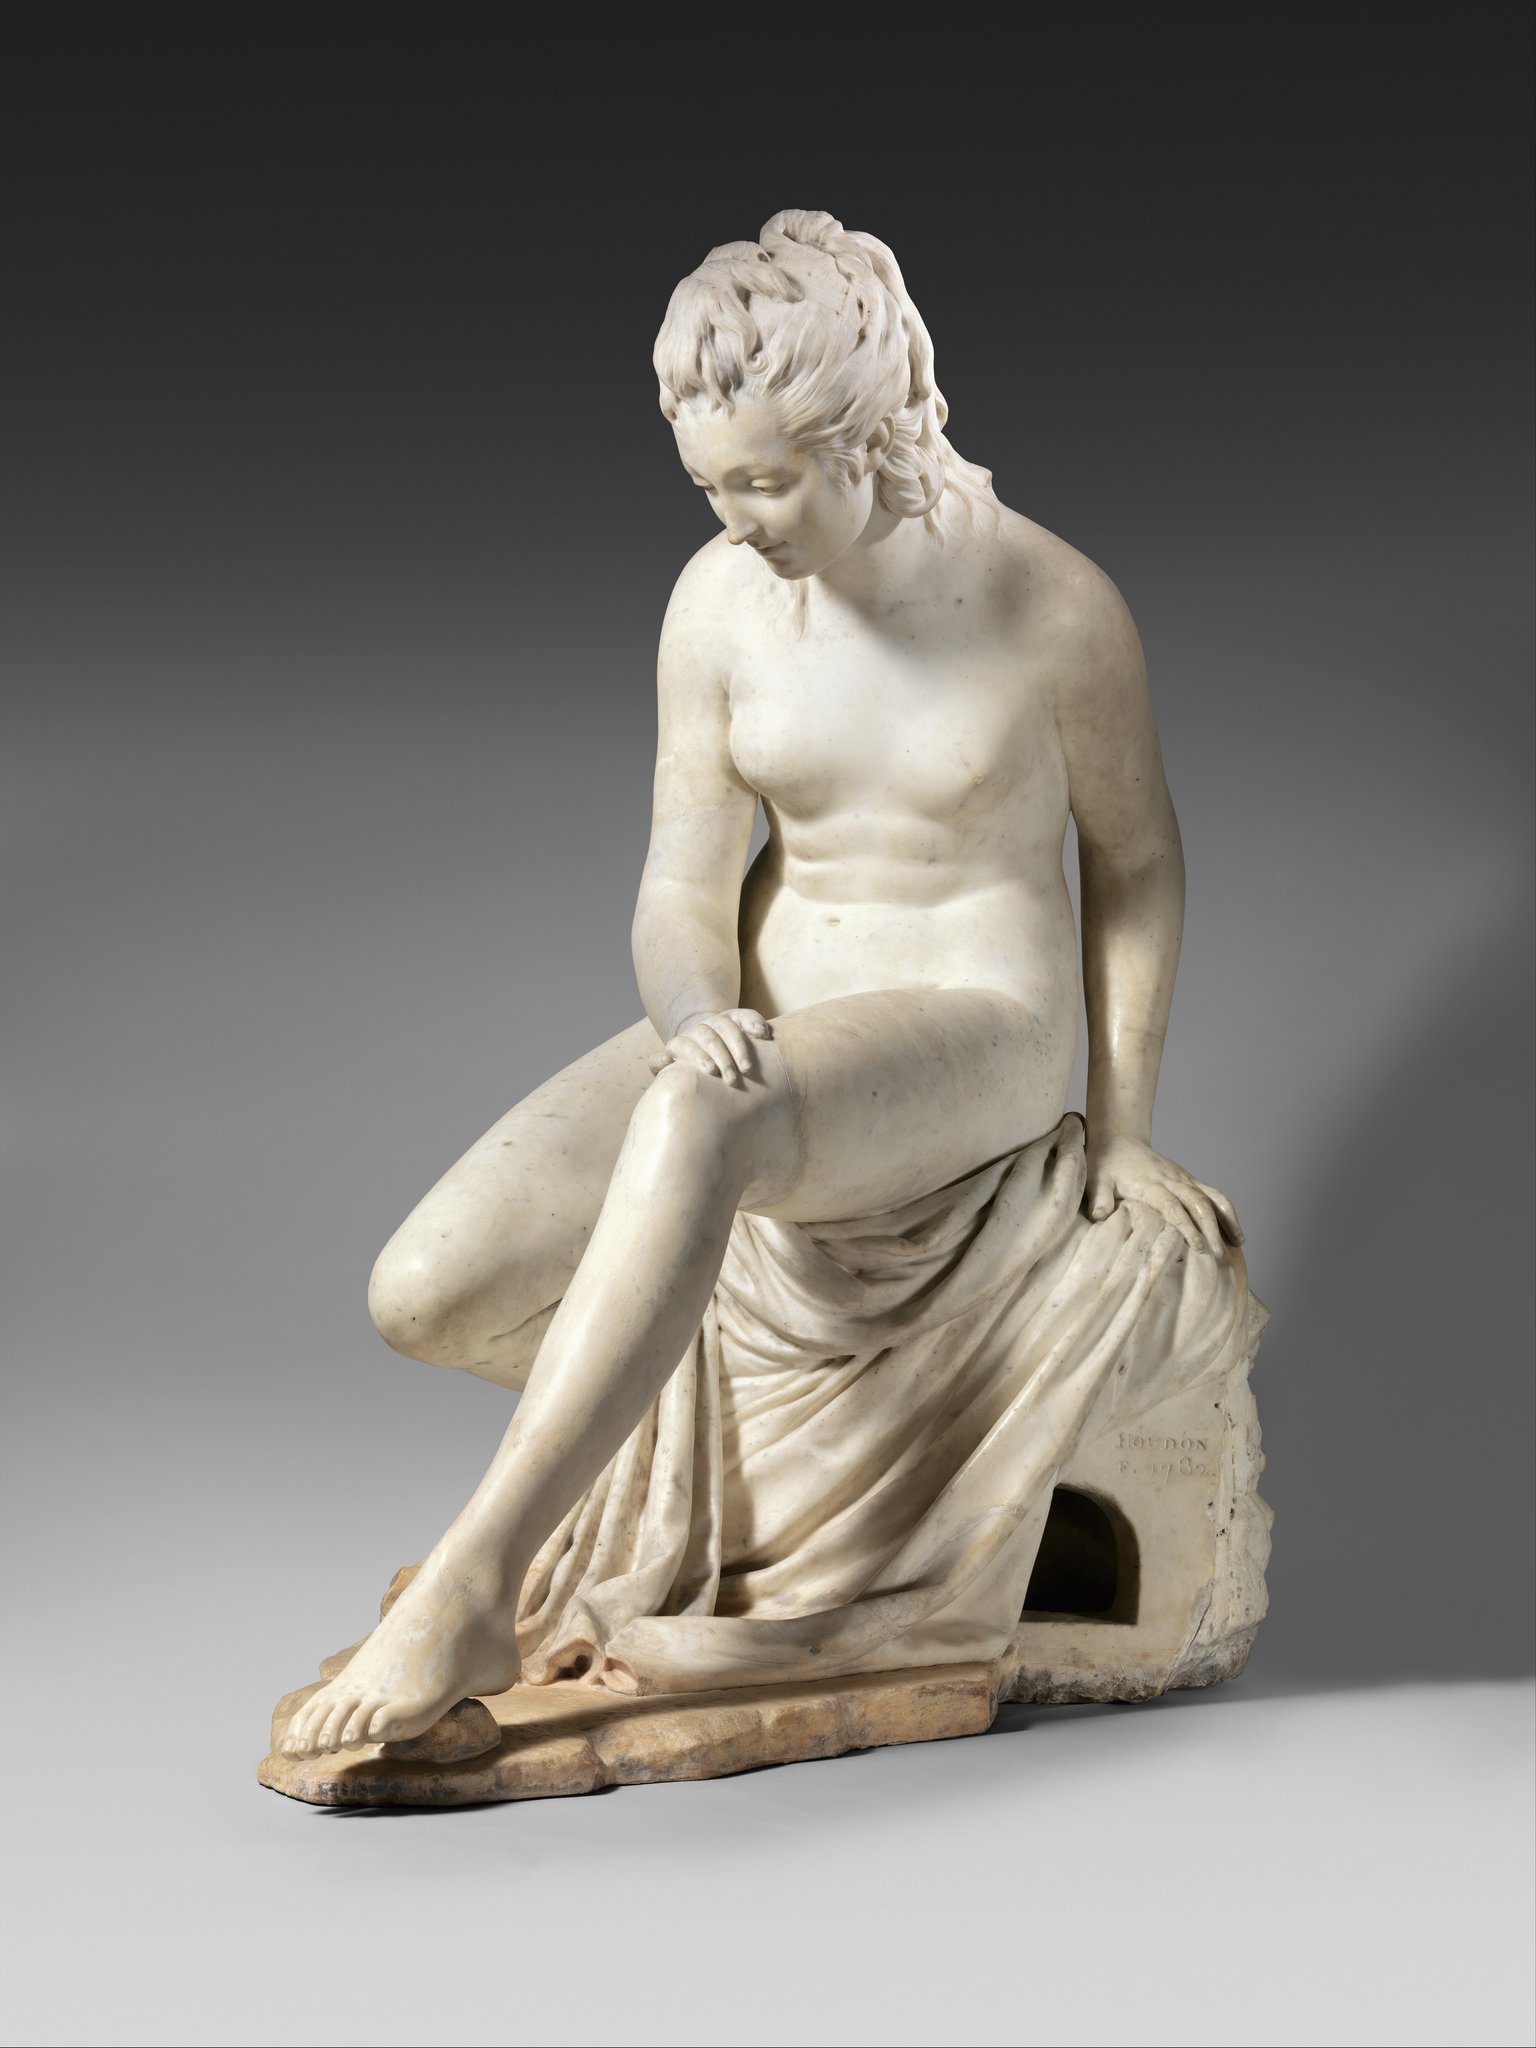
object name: statue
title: Bather (from a fountain group)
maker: jean antoine houdon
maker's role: artist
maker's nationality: french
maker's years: 1741-1828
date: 1782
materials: marble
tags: female nudes,bathing